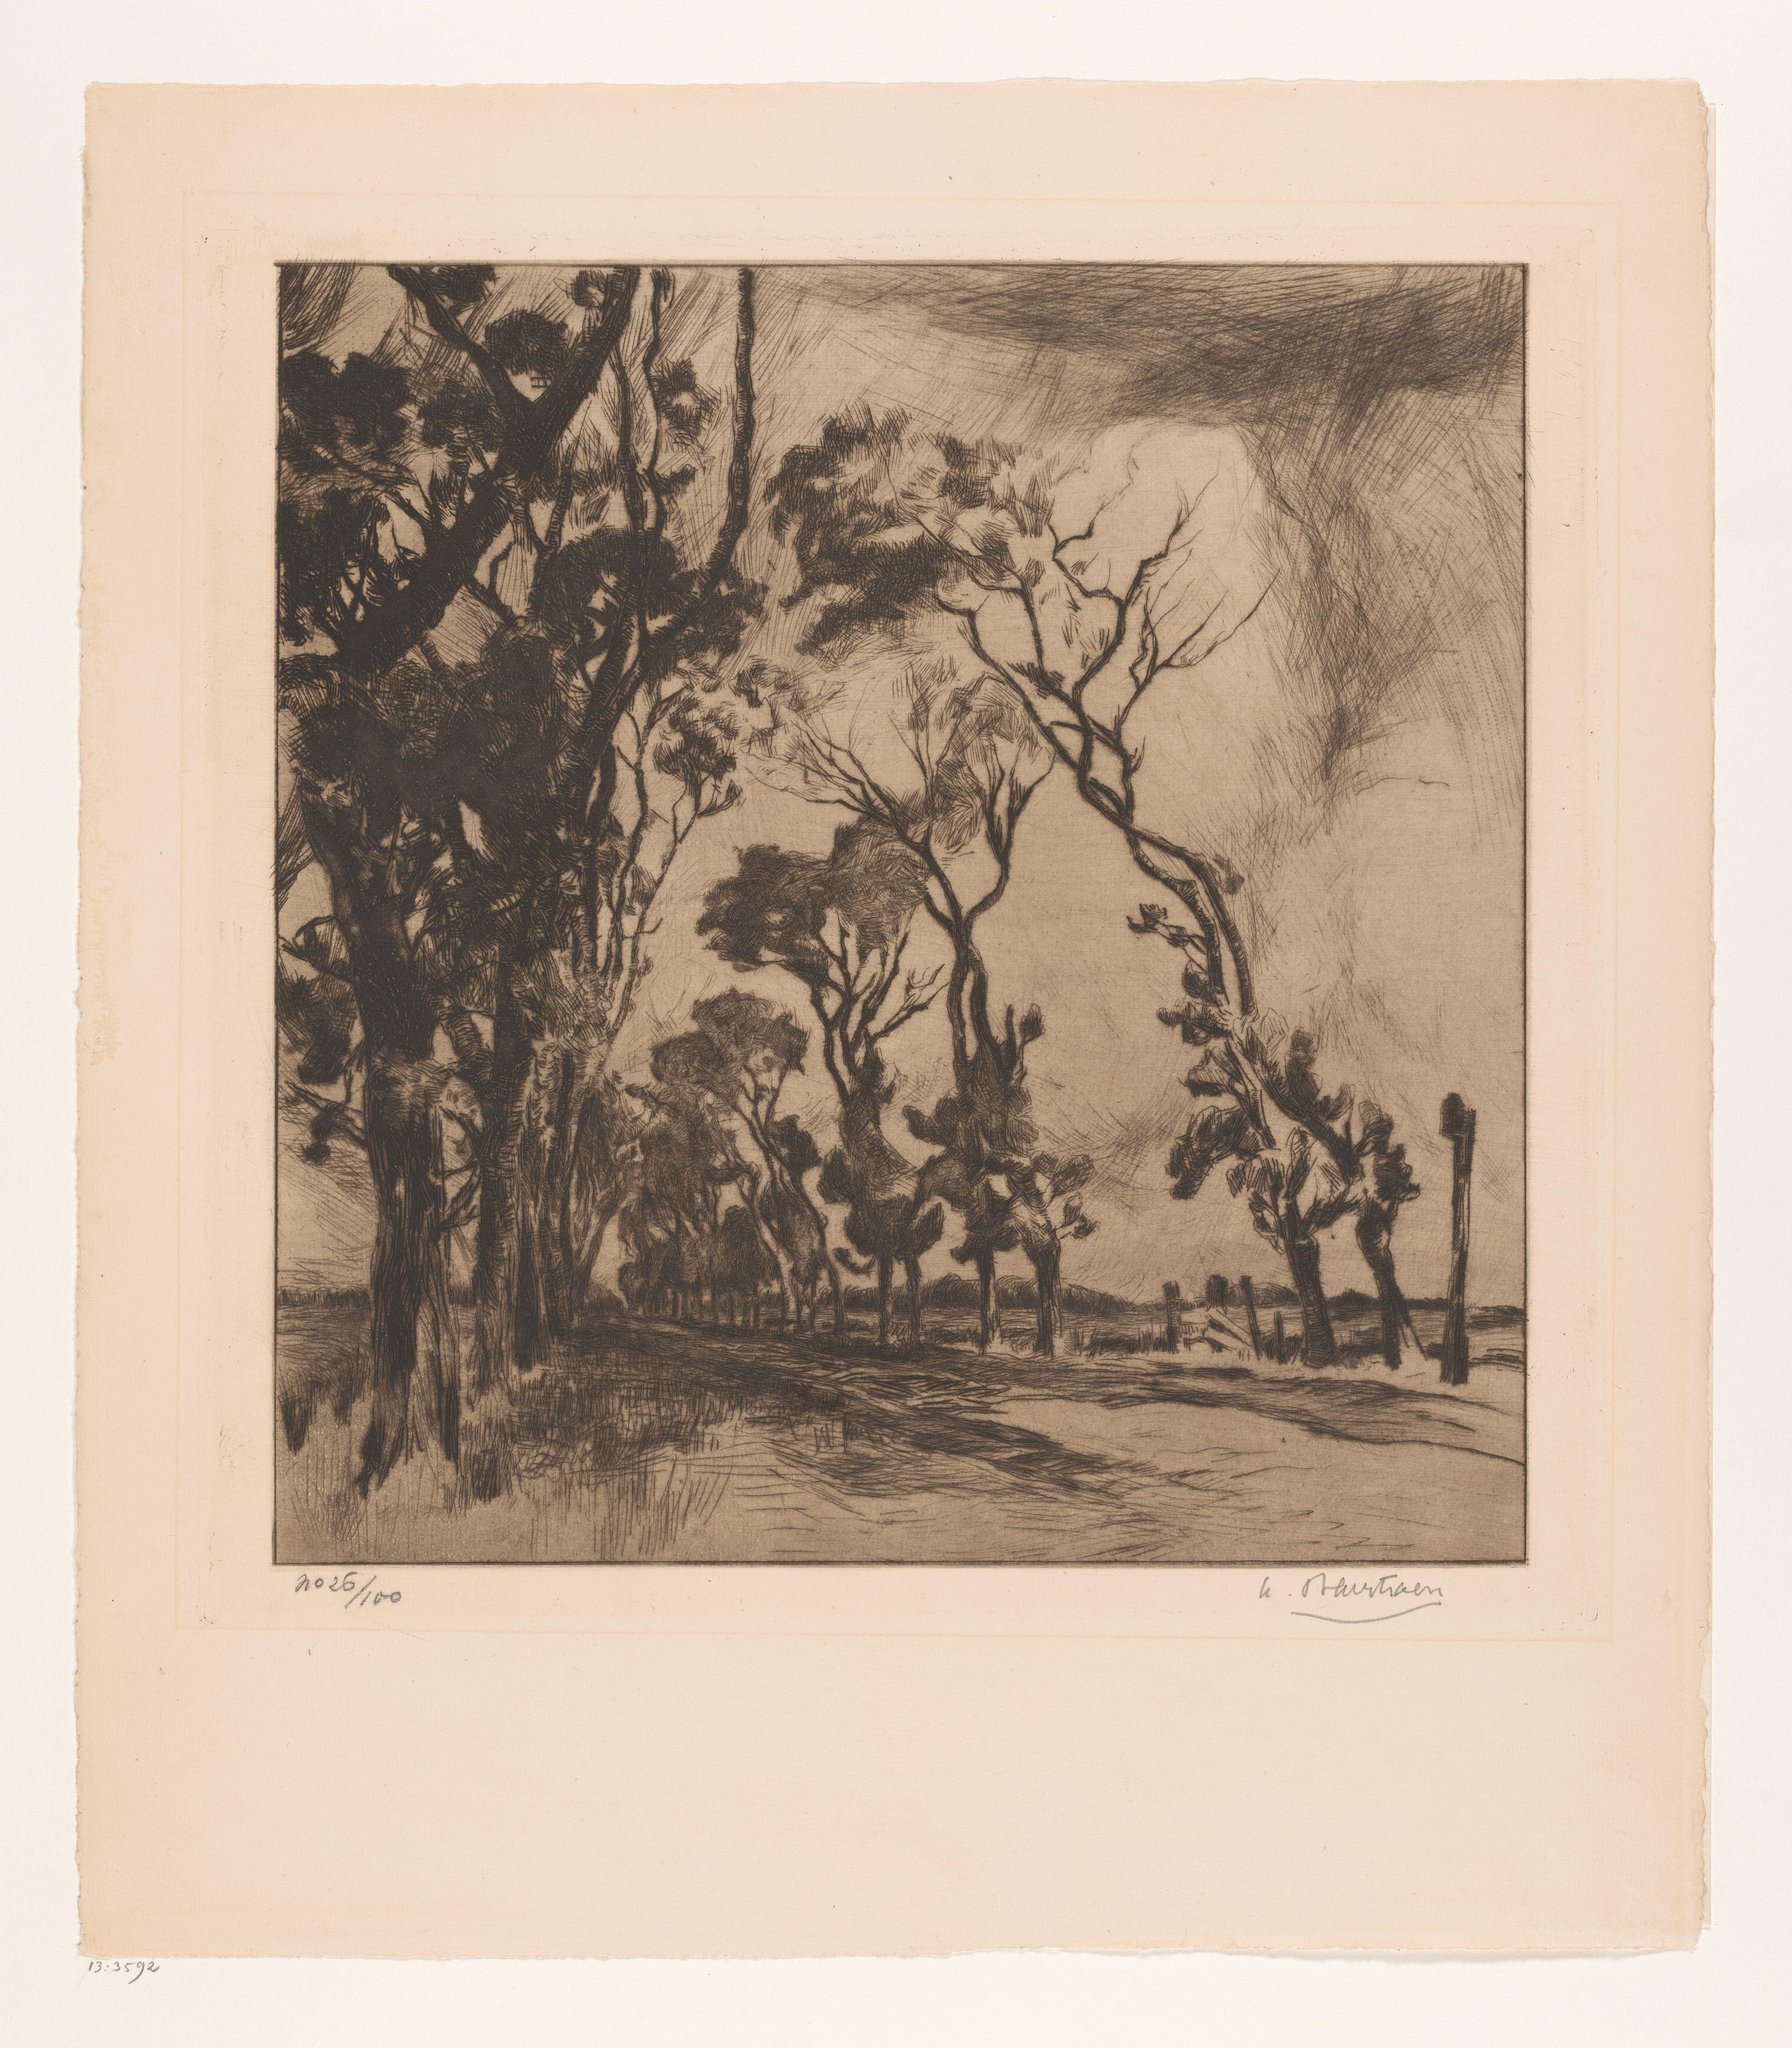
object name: print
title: Landschap met laan richting Oostende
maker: albert baertsoen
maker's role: draughtsman, print maker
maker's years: 1866-1922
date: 1876-1913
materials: paper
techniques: drypoint, etching, intaglio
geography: belgium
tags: landscapes in the temperate zone, forest path or lane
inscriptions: annotation: ‘1a/ 12/77 [in getekende driehoek]’, collector's mark: Lugt 2228, collector's mark: Lugt 2233